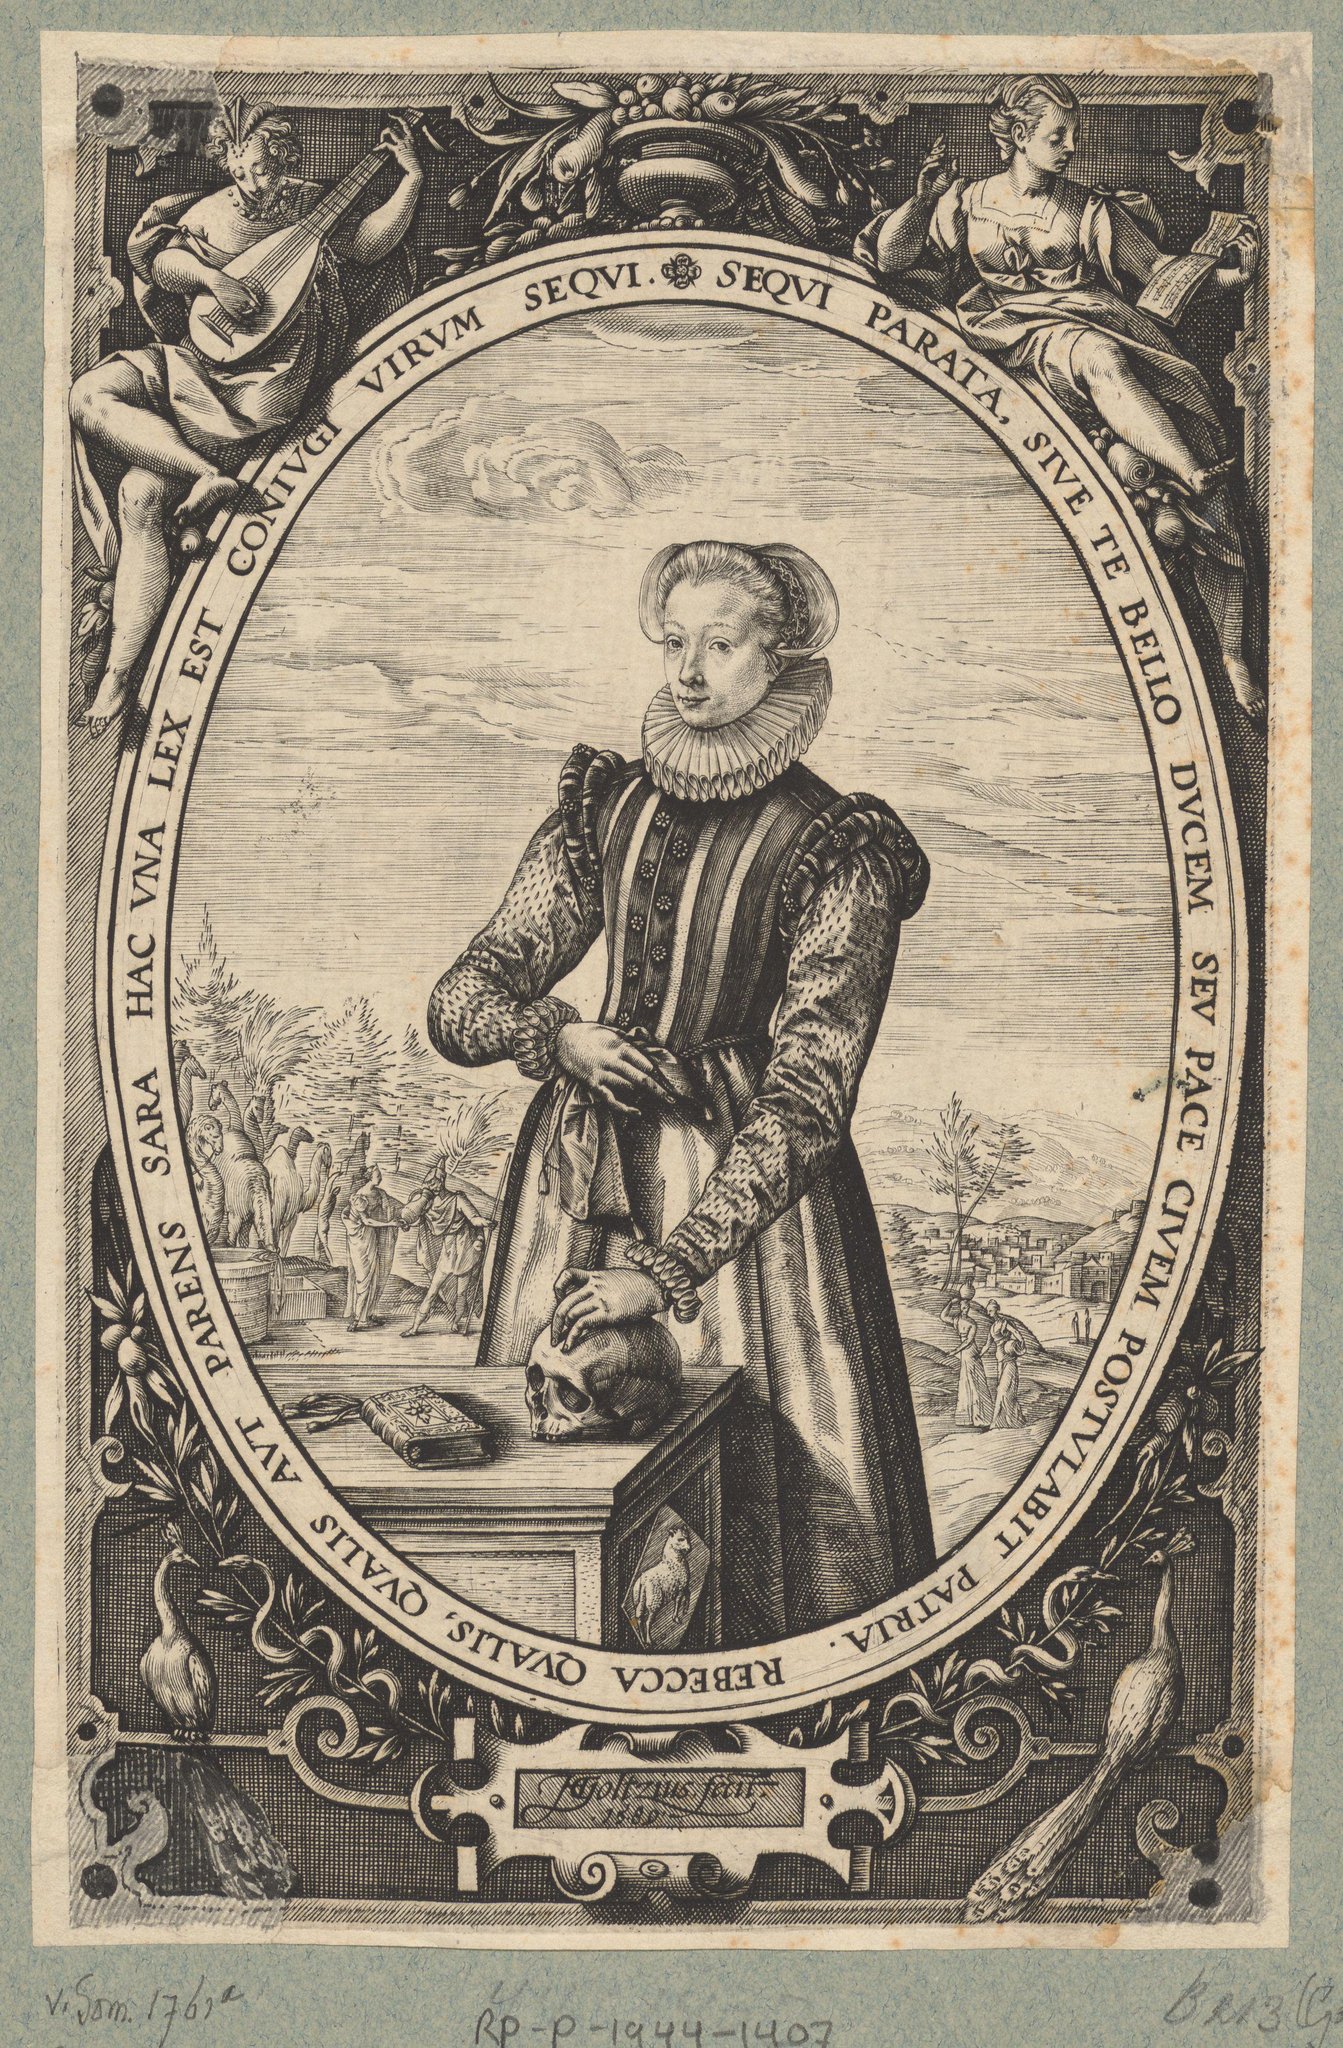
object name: print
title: Portret van Josina Hamels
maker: hendrick goltzius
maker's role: draughtsman, painter, print maker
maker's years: 1558-1617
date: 1580-1589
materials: paper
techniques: engraving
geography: haarlem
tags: hoofed animals: camel, notation of music, (human) skull, historical persons - bb - woman, ornamental birds: peacock, lute, and special forms of lute, e.g.: theorbo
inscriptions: collector's mark: Lugt 3937, collector's mark: Lugt 240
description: Kniestuk, staand achter tafel waarop een boek en doodshoofd liggen. De linkerhand rust op het doodshoofd, in de rechterhand een zakdoek met kwastjes. Op de achtergrond mensen en kamelen bij een waterput. In ovaal met randschrift. Het ovaal zelf weer in ornamentale omlijsting waarin bovenaan twee vrouwen zijn afgebeeld, een met muziekboek en een met luit. Onderaan twee pauwen. Pendant van portret van echtgenoot Jacques de la Faille.